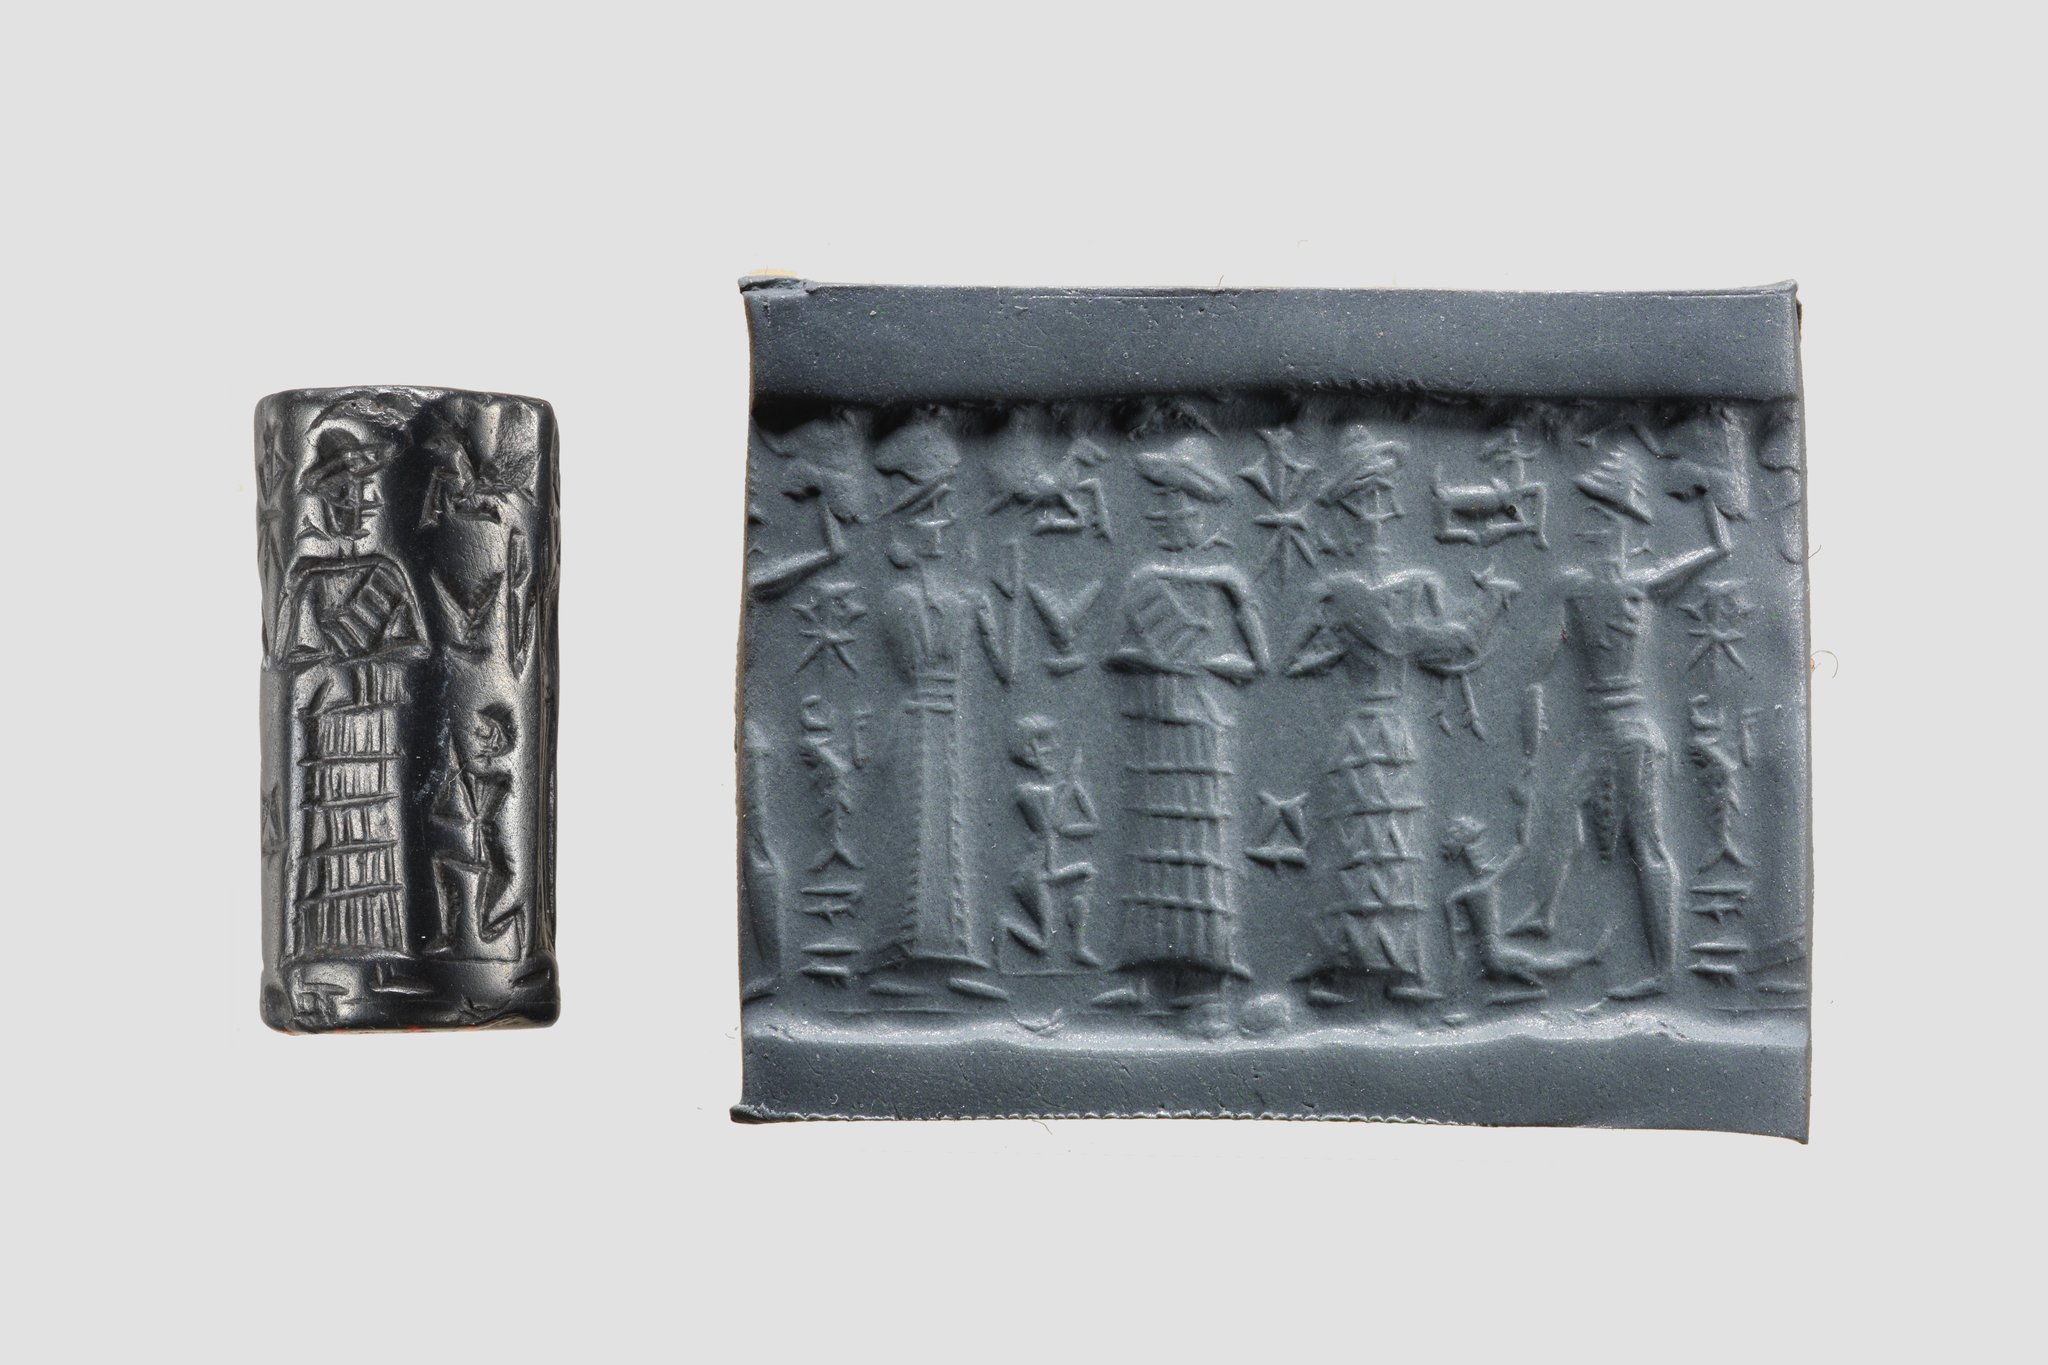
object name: cylinder seal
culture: babylonian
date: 2000-1668 BCE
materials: mineral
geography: mesopotamia